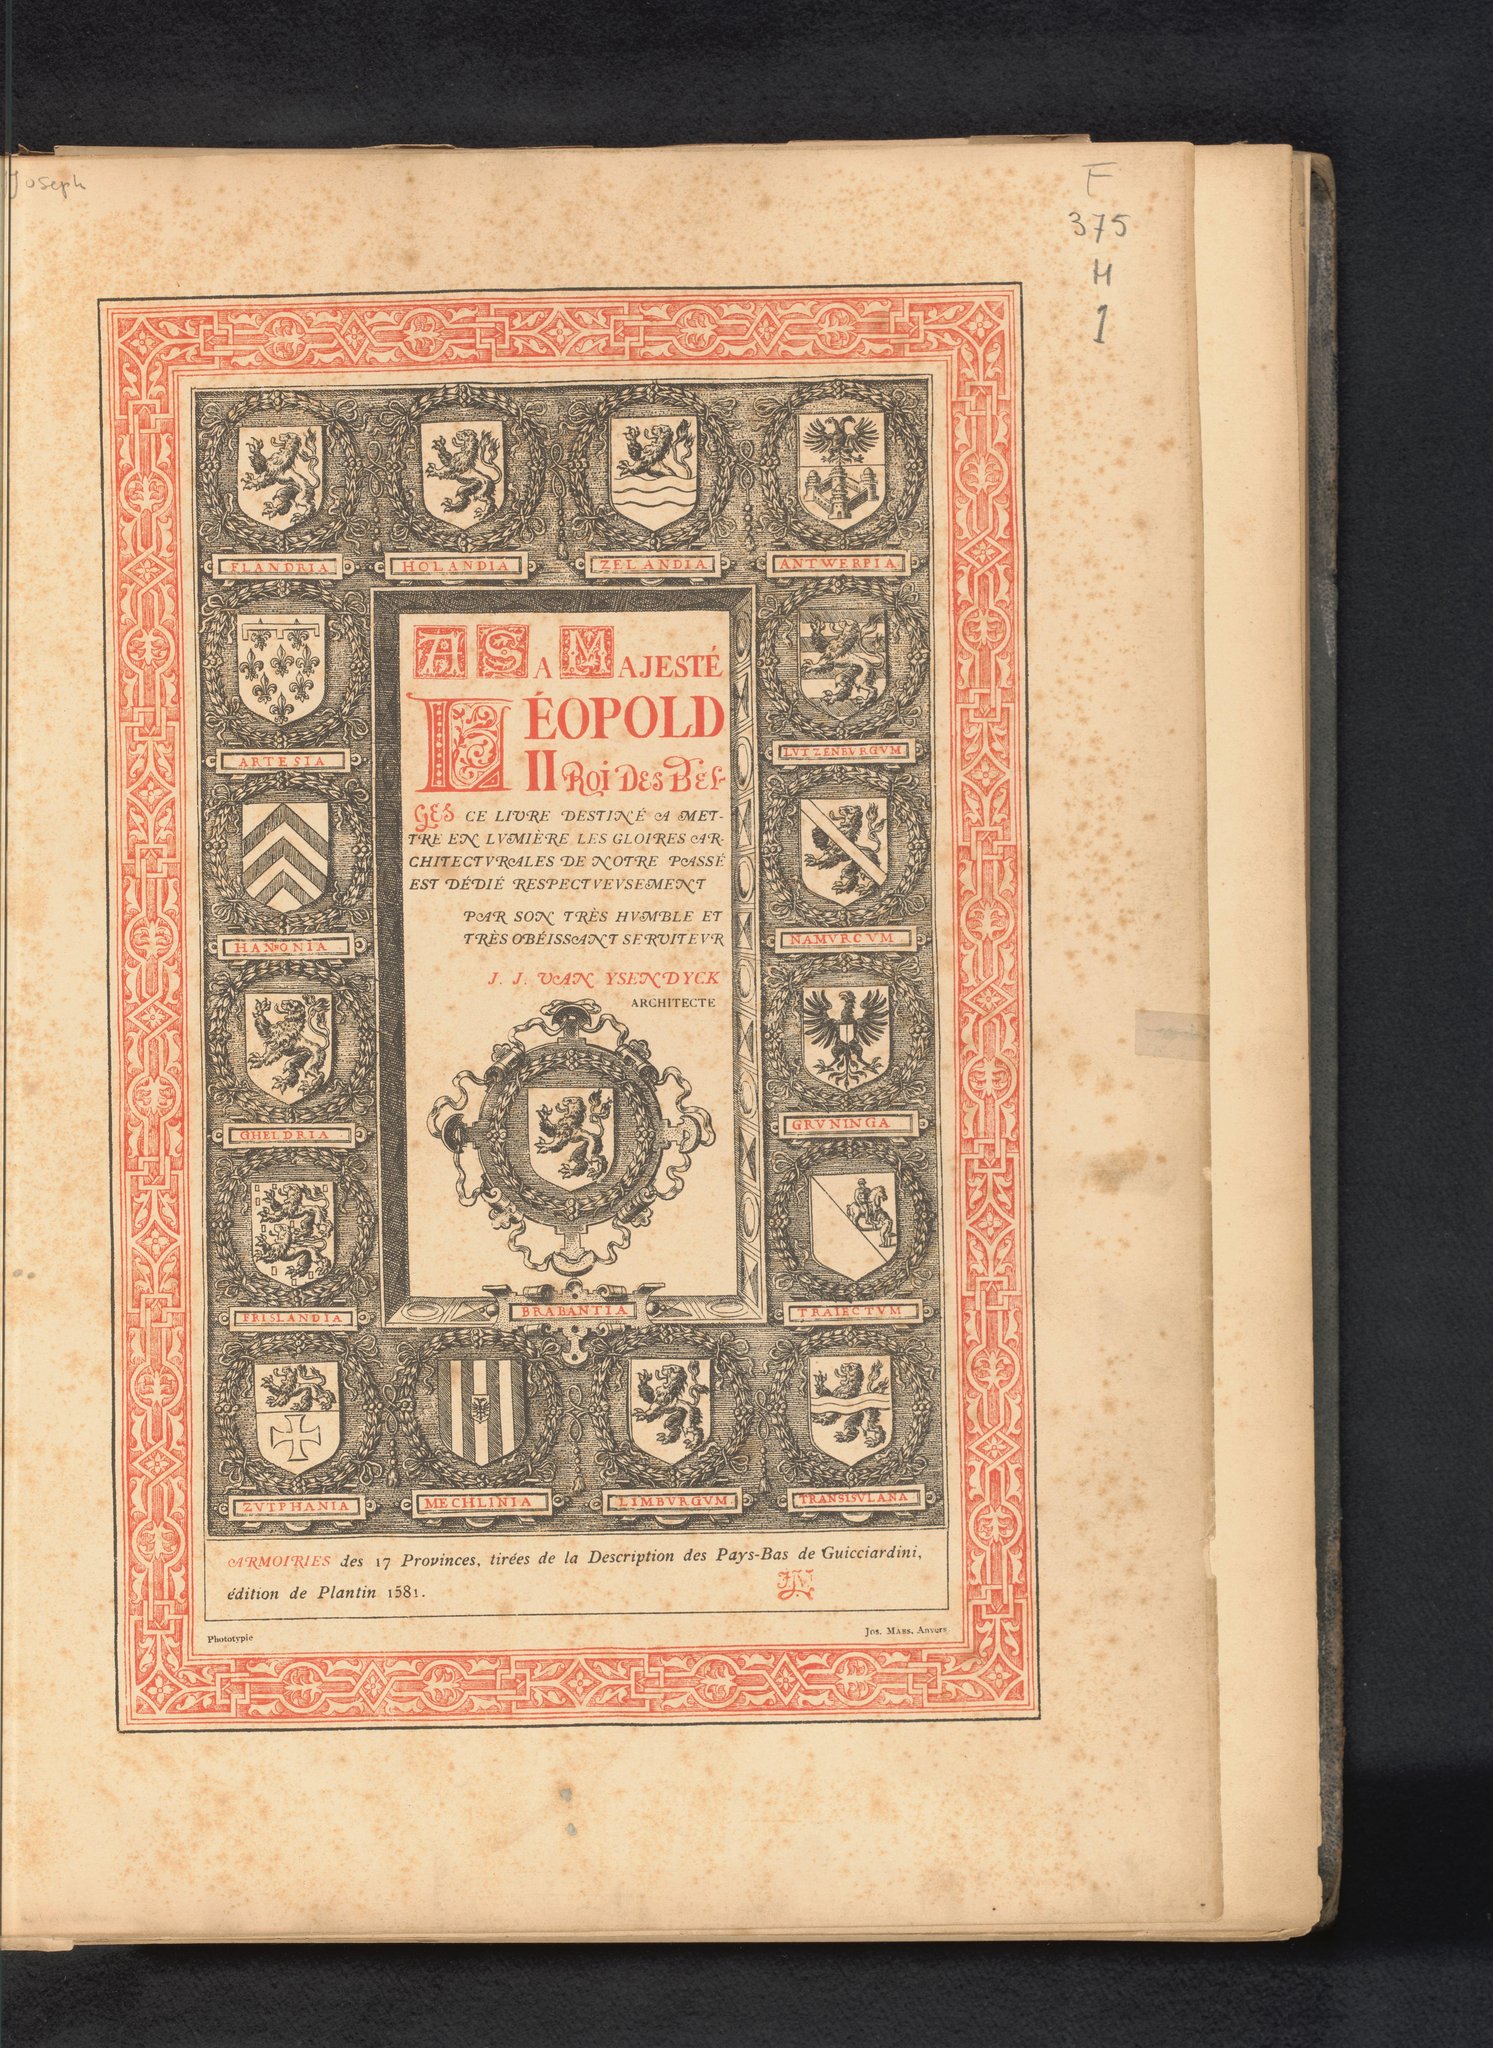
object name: reproduction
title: Reproductie van een titelpagina met wapenschilden van De Zeventien Provinciën der Nederlanden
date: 1875-1880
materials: paper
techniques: photolithography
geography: antwerp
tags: coat of arms (as symbol of the state, etc.), title-page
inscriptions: monogram: ‘JJvY’, inscription: ‘Armoiries des 17 (...)’